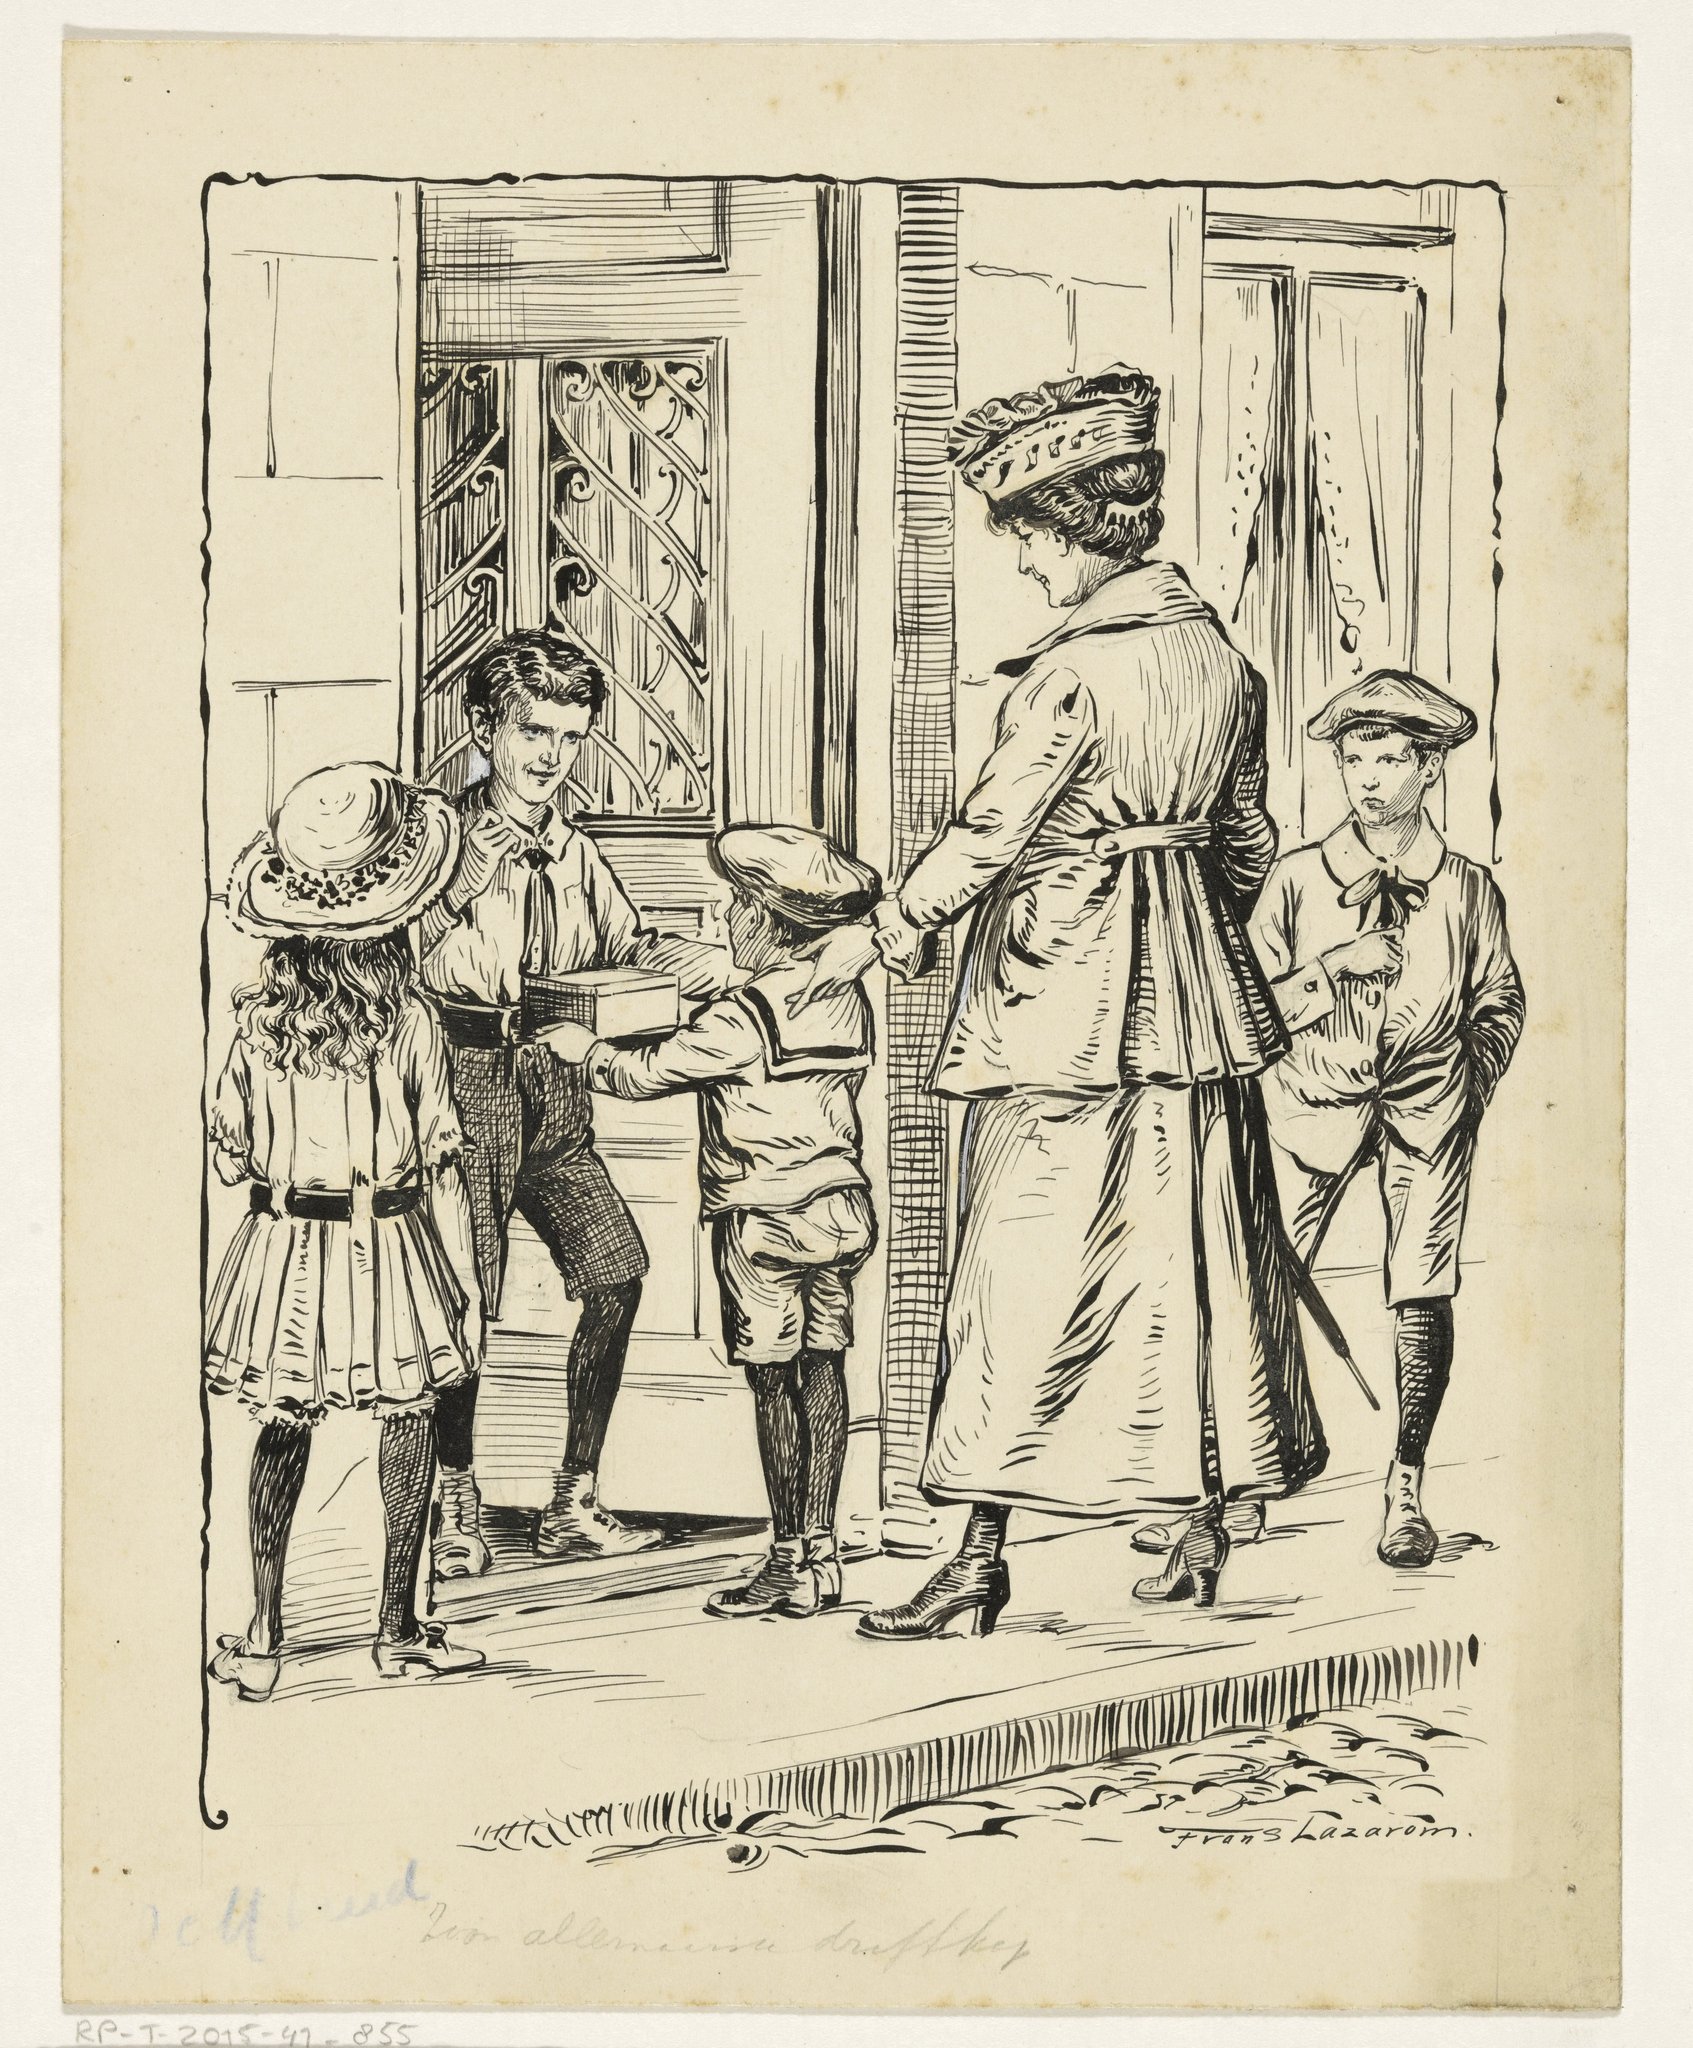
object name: drawing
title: Jopie biedt een trommel aan bij een deuropening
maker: frans lazarom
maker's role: draughtsman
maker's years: 1880-1936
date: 1916-1917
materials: paint, ink, paper, pencil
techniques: pen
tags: containers, non-aggressive relationships, boy (child between toddler and youth)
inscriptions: annotation: ‘zoon allermooiste dr[...]’, collector's mark: Lugt 2228, :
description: Jopie, gekleed in een matrozenpak, staat met een dienblad met daarop een trommel bij een deuropening. Zijn tante geeft hem een duwtje in de rug. De jongen biedt de doos aan aan Jaap die in de deuropening staat.